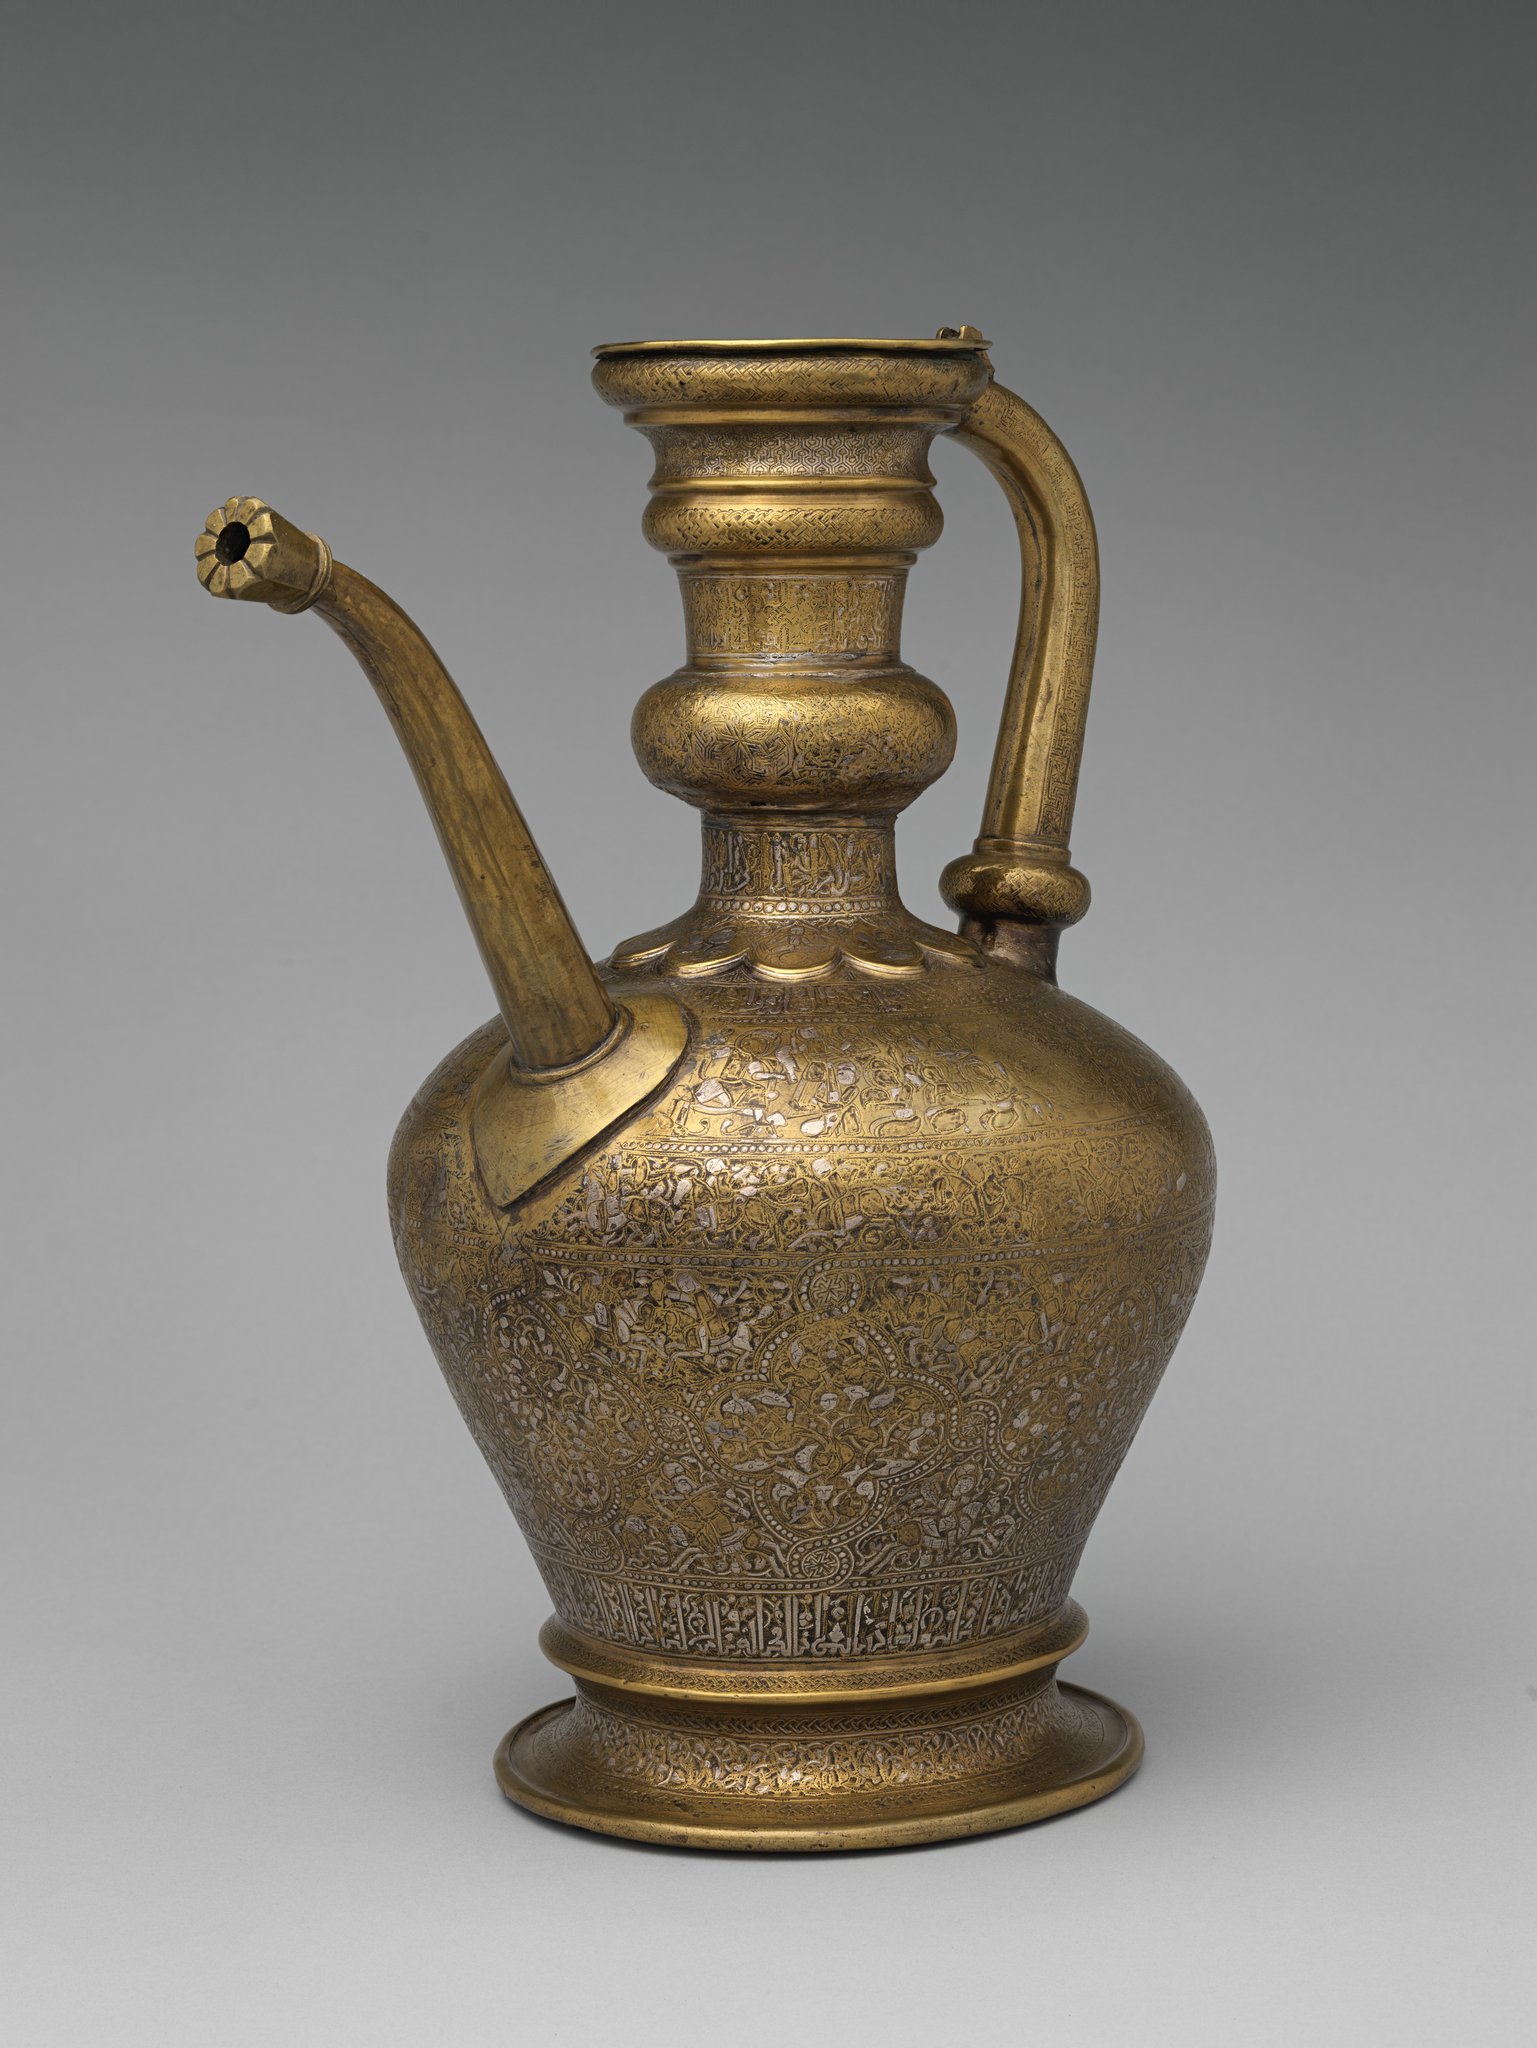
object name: ewer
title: Ewer with Inscription, Horsemen, and Vegetal Decoration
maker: `umar ibn al-hajji jaldak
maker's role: maker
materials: brass, silver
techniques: inlay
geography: iraq